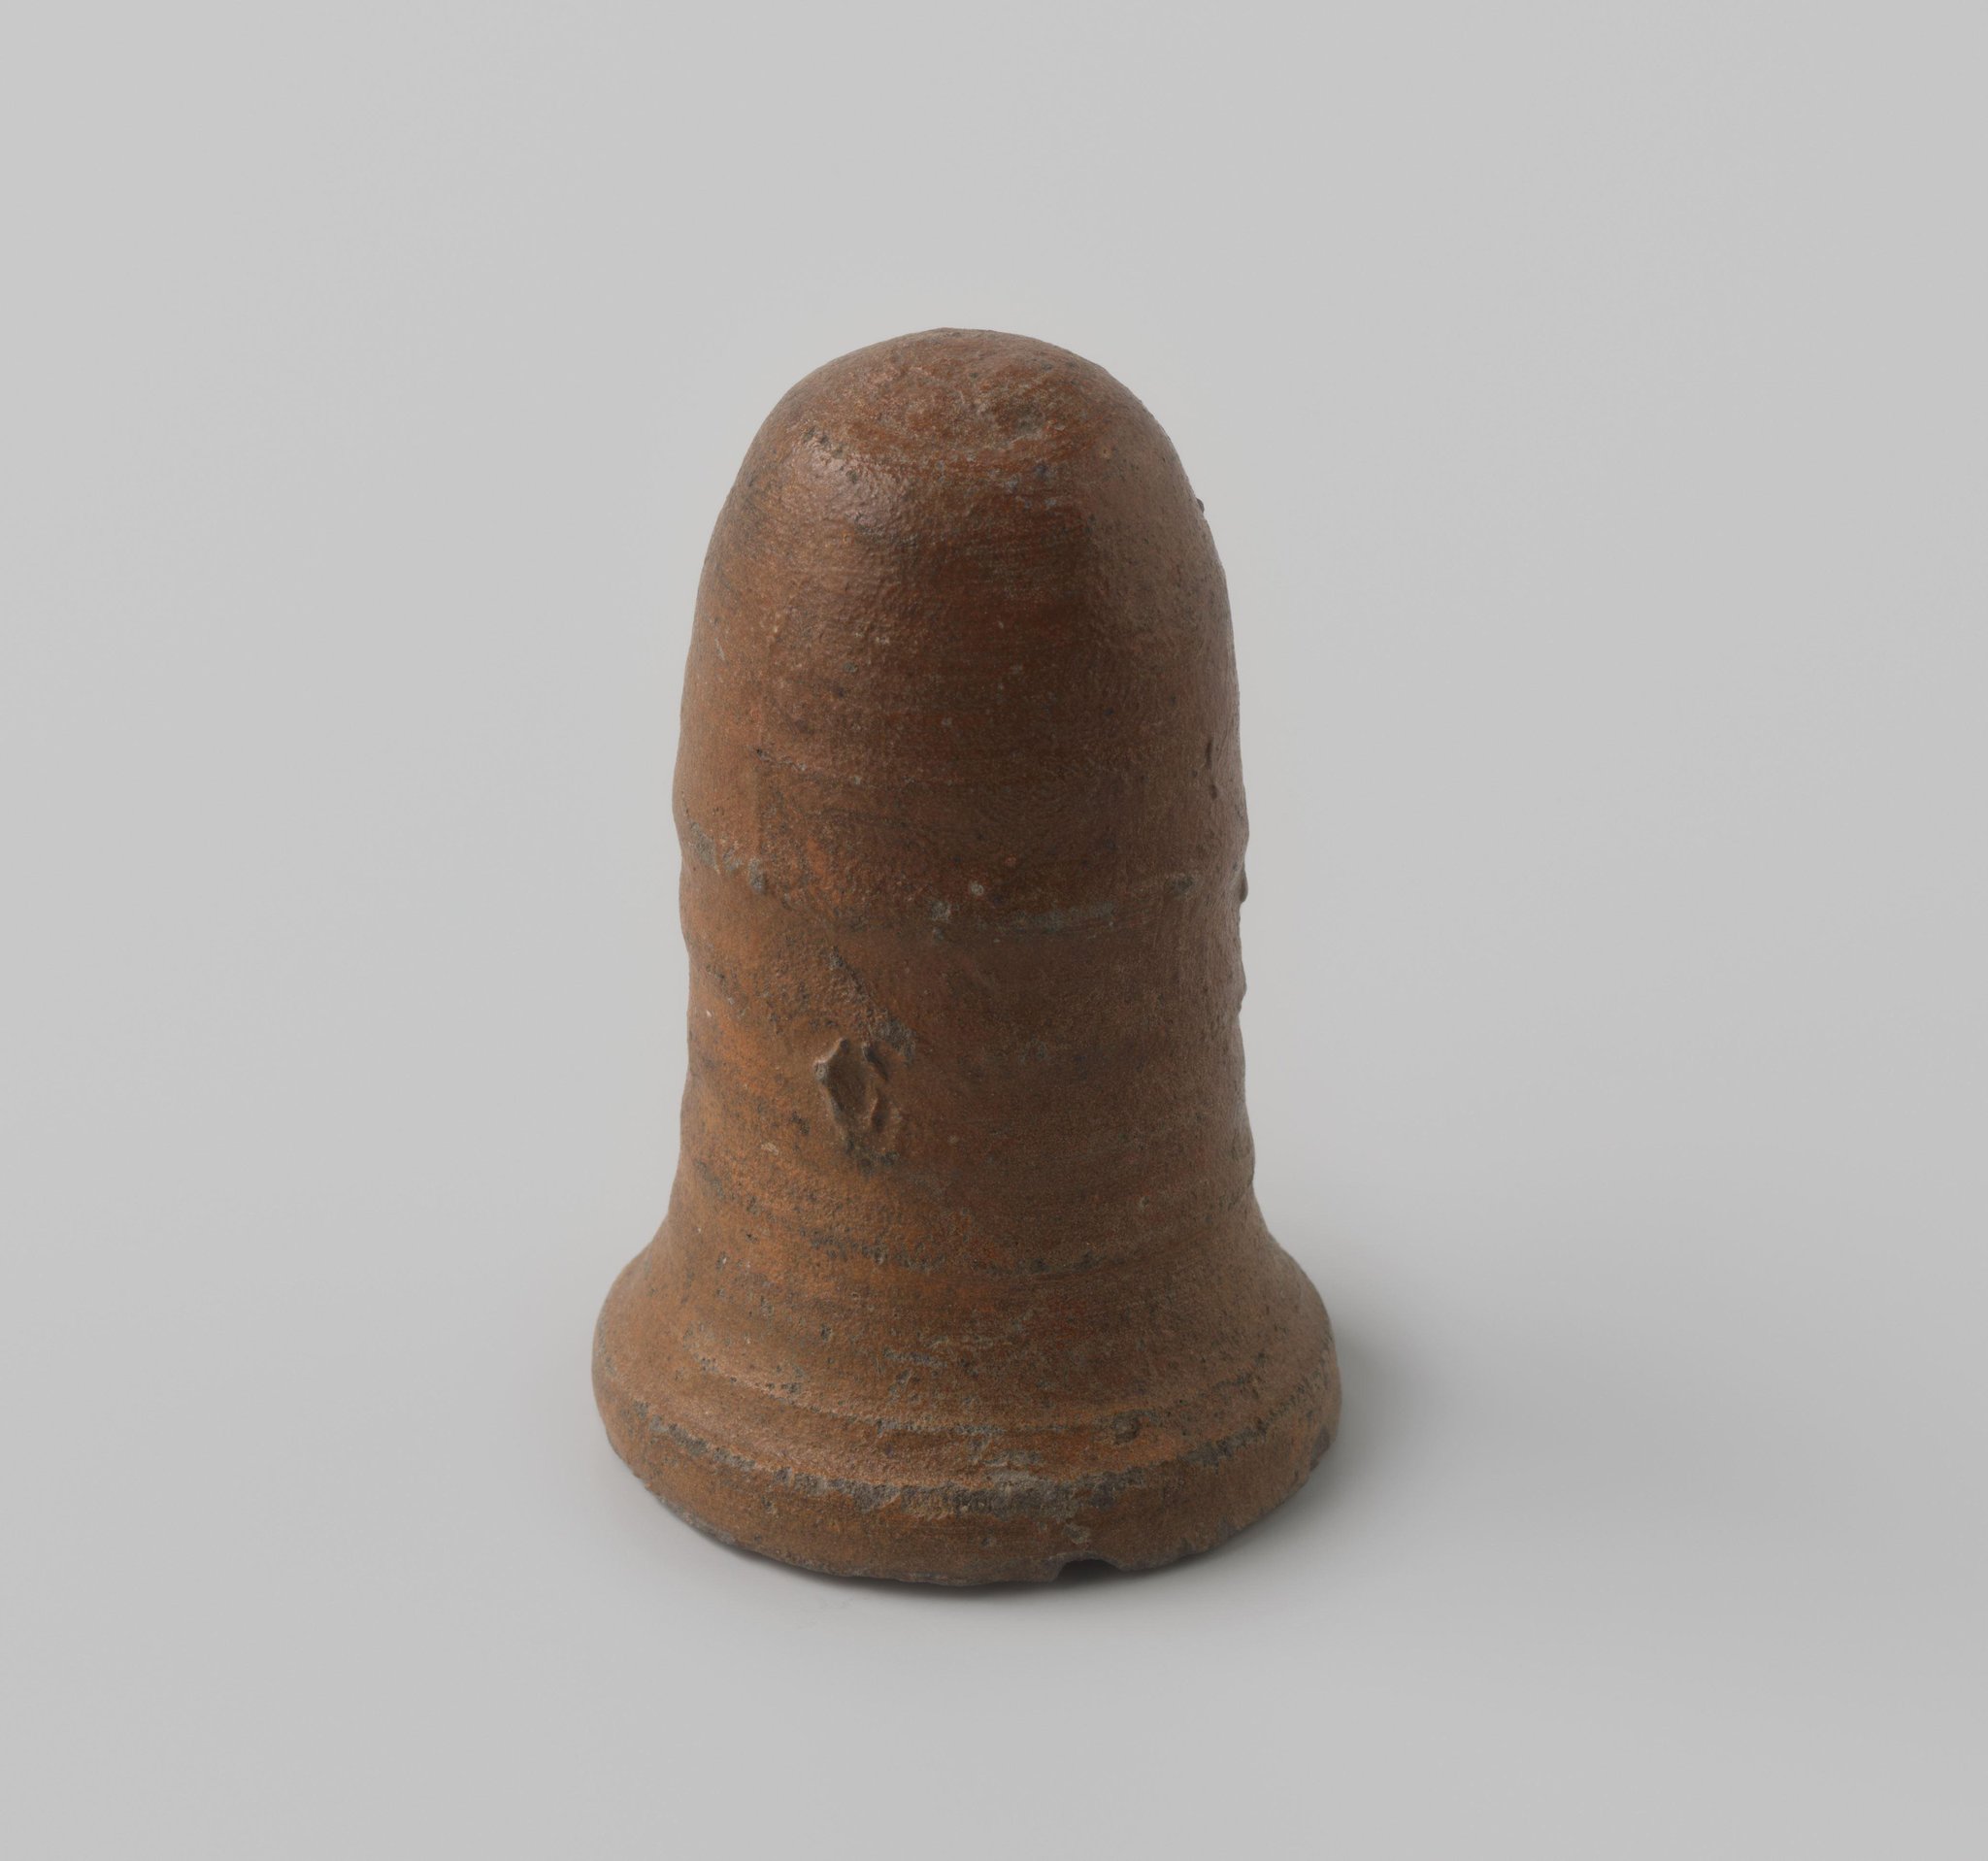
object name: bung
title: Stop in de vorm van een kegel met afgeronde punt, van grijs steengoed voorzien van roodbruine glazuur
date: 1500-1899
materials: glaze, stoneware